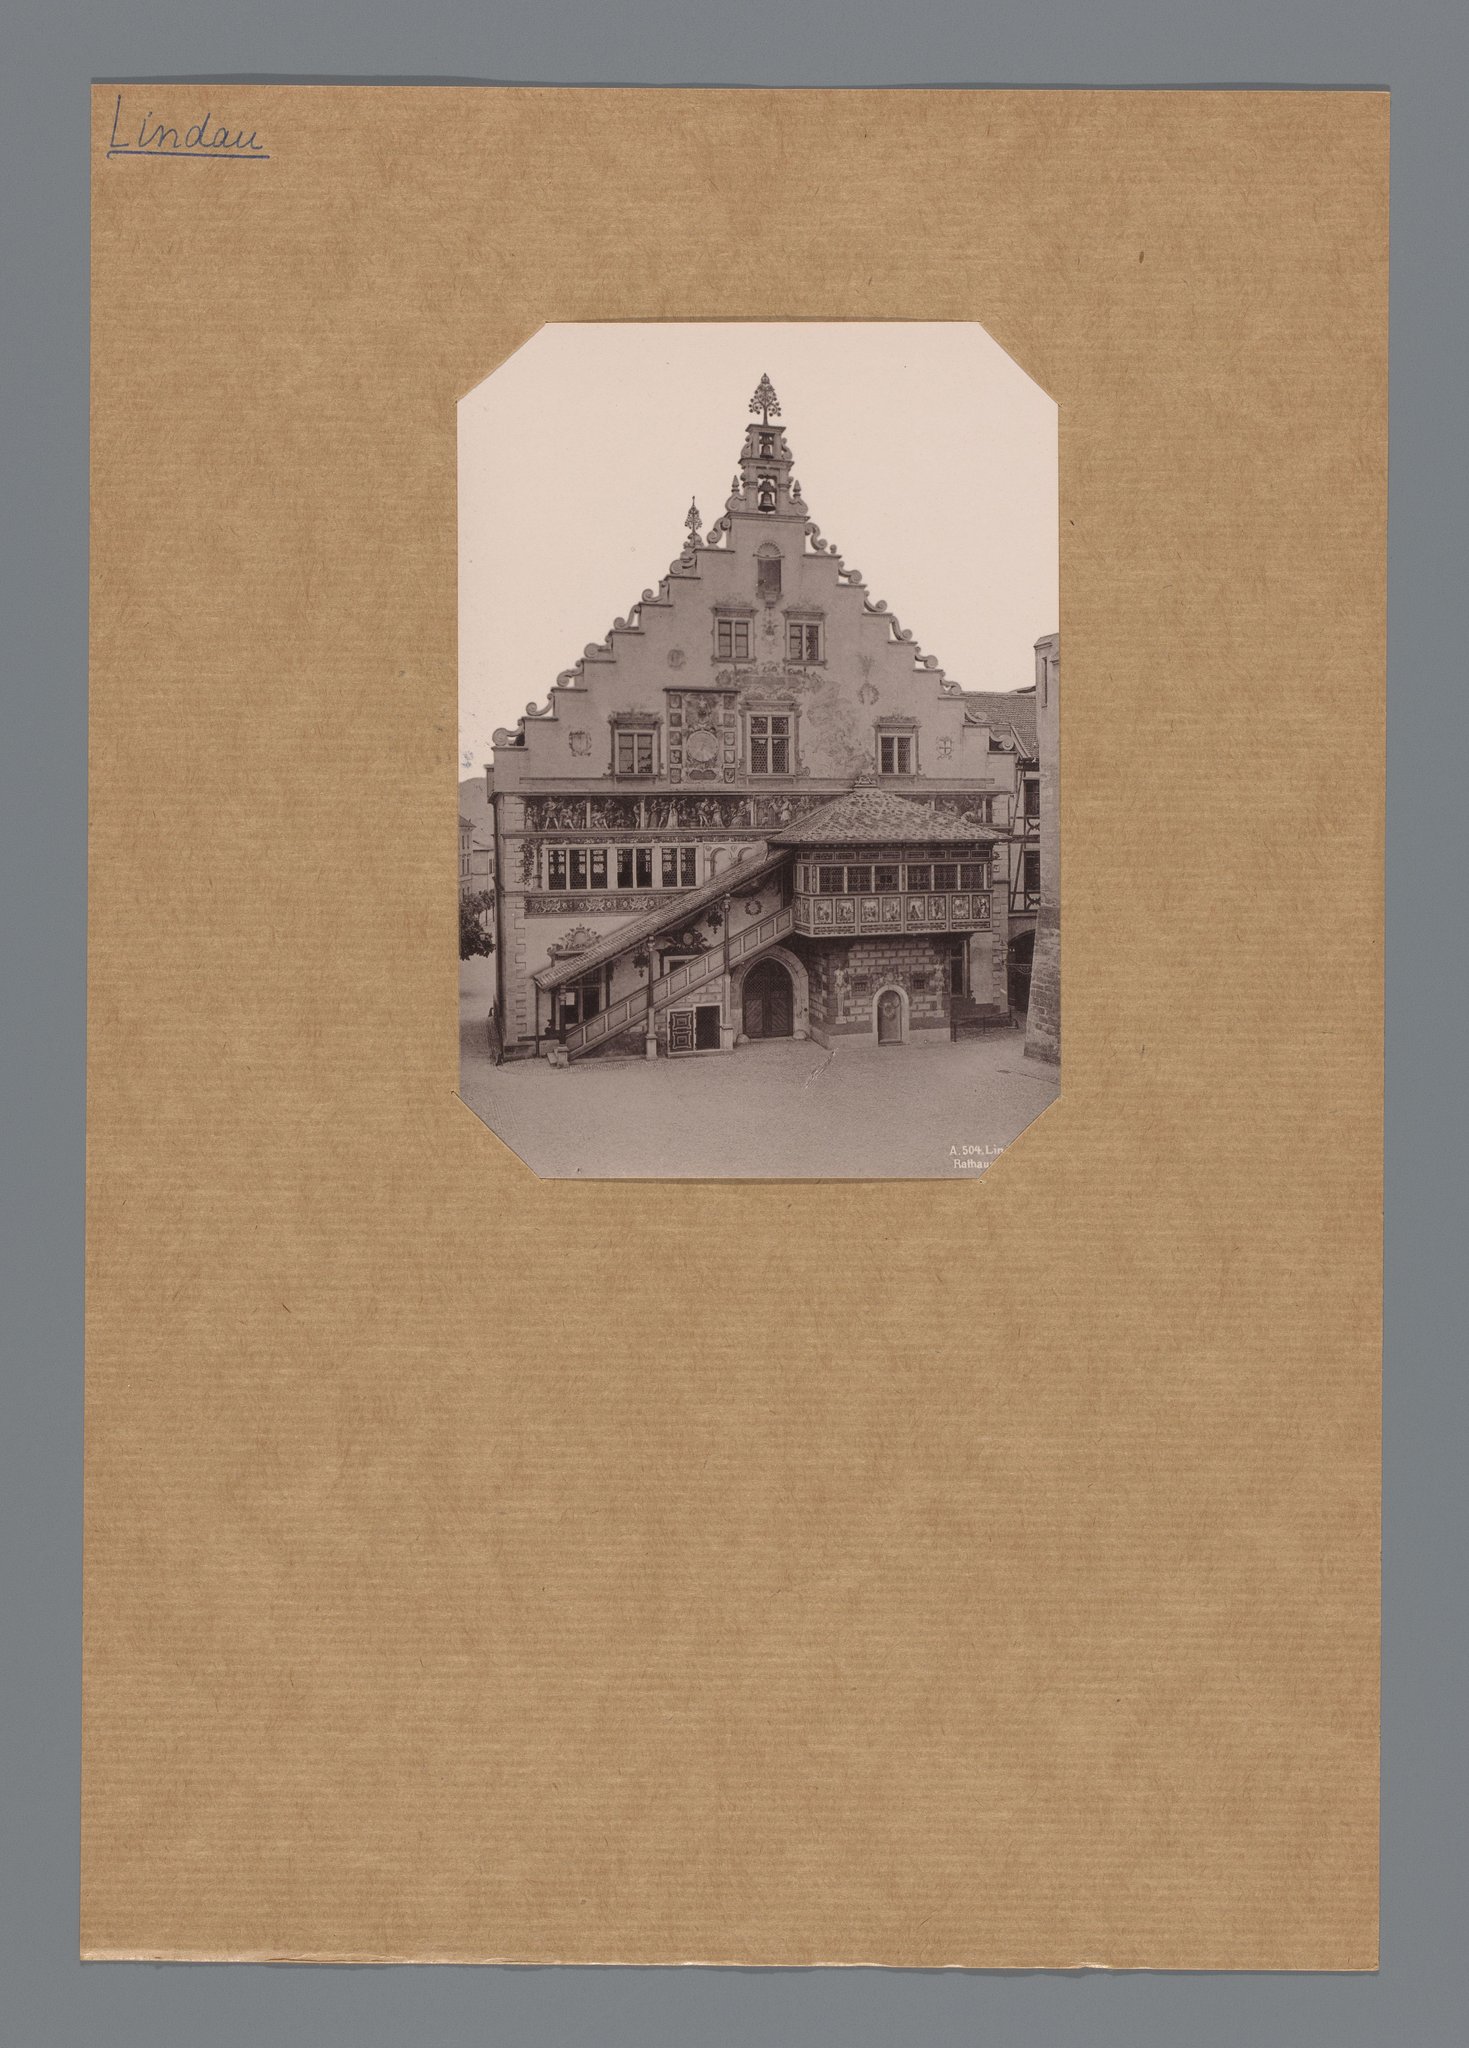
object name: photograph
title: Luebeck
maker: Anonymous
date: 1880-1920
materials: photographic process, photographic support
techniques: photograph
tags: lübeck